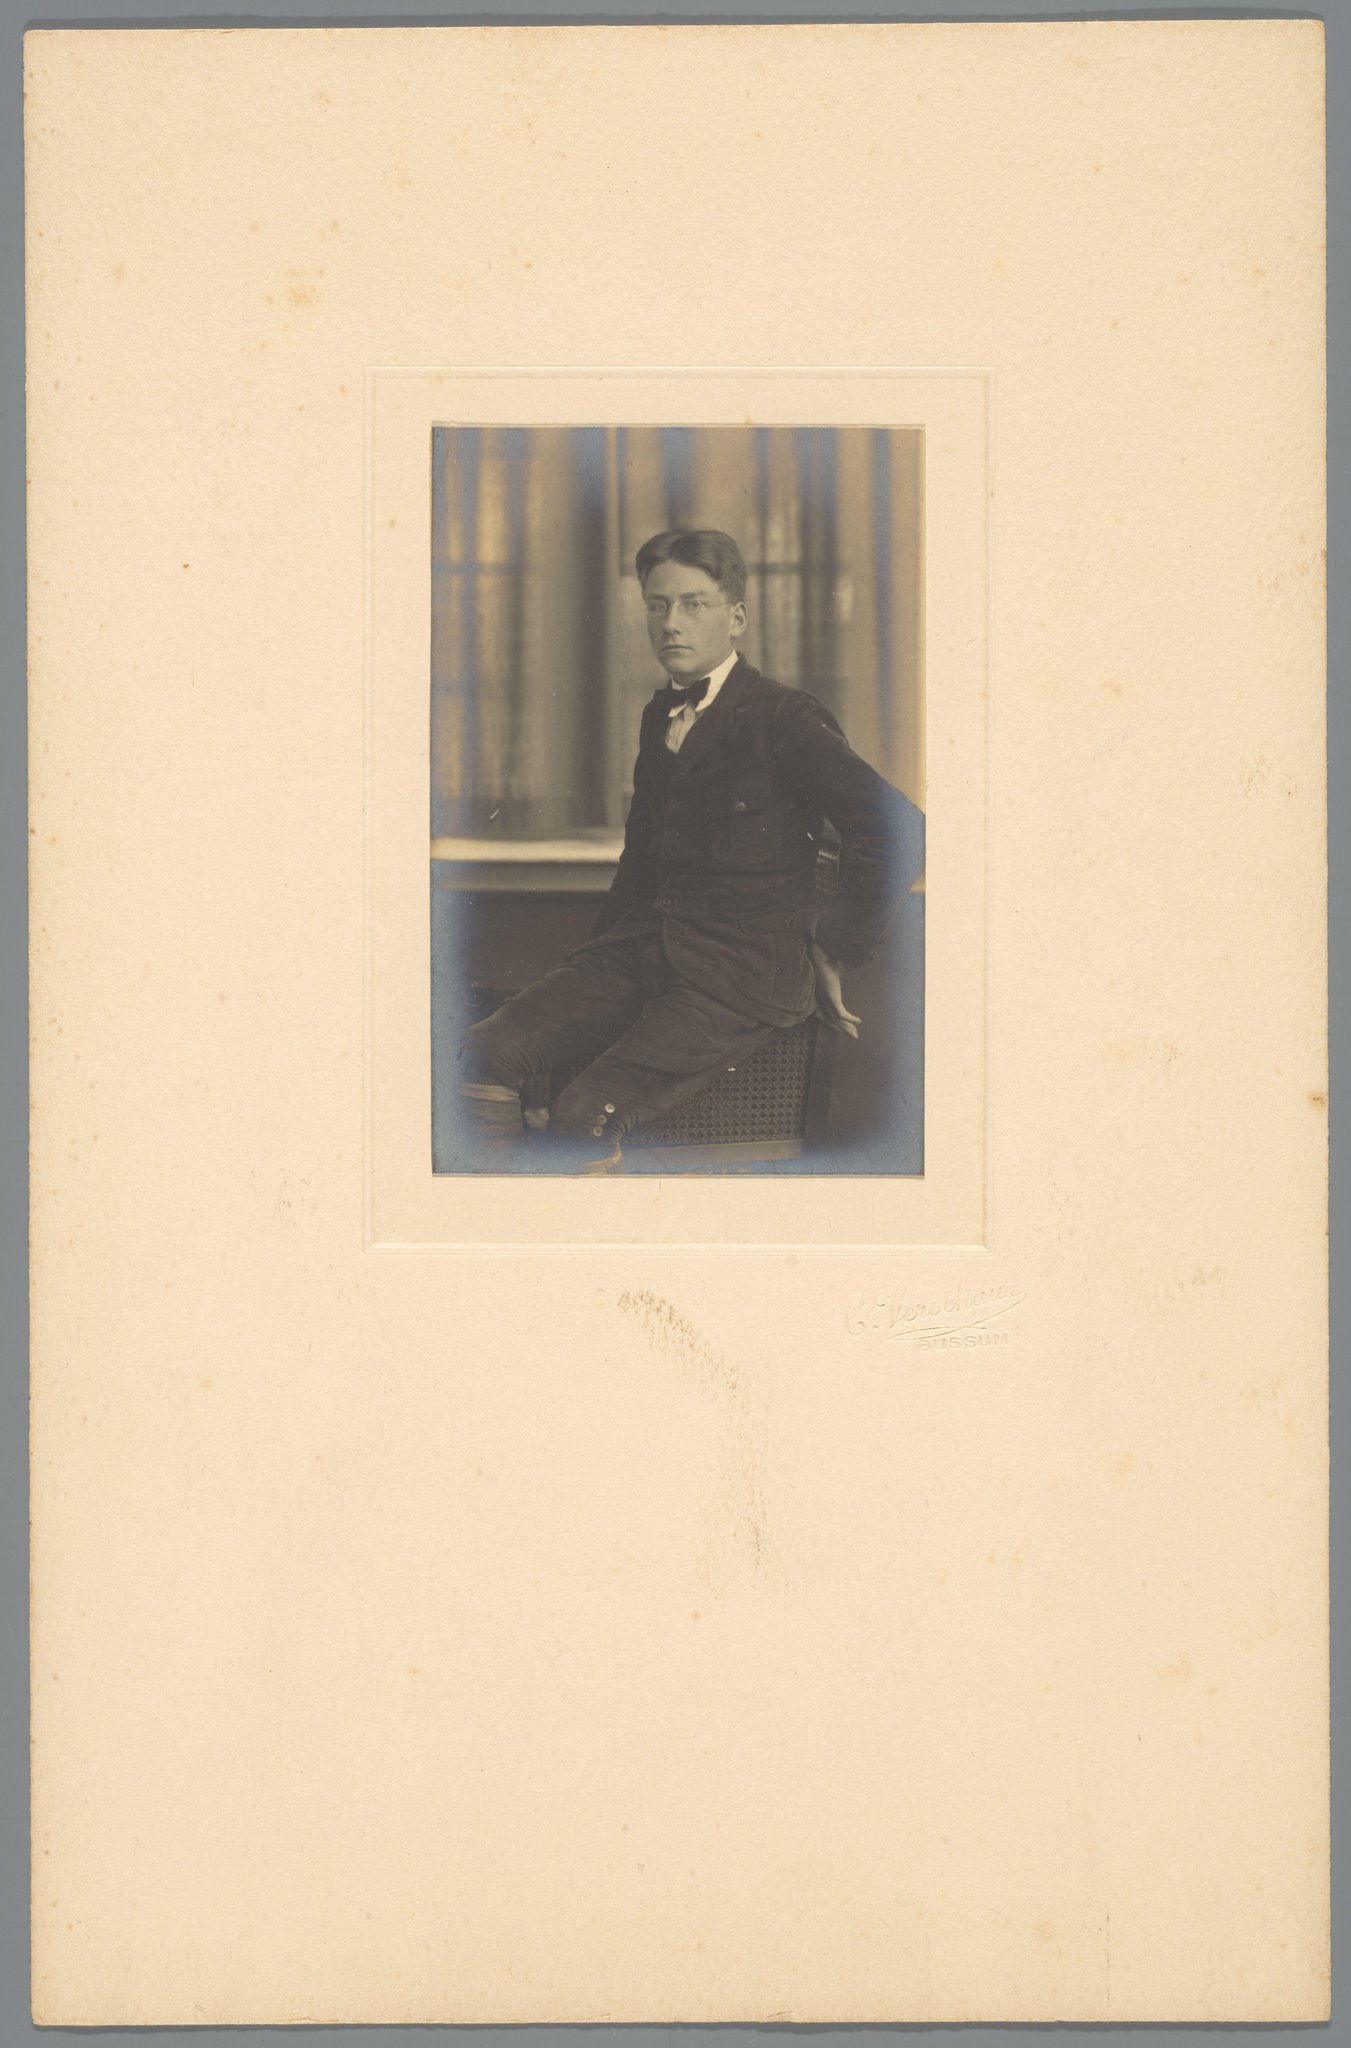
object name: photograph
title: Portret van Goverdus Henricus Jonker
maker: coenraad verschuur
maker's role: fotograaf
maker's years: 1882-1959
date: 1910-1940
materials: cardboard, photographic support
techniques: gelatin silver print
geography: bussum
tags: historical persons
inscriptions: workshop stamp: ‘C. Verschuur/ Bussum’, annotation: ‘G.H. Jonker/ geb. 6-7-1901’